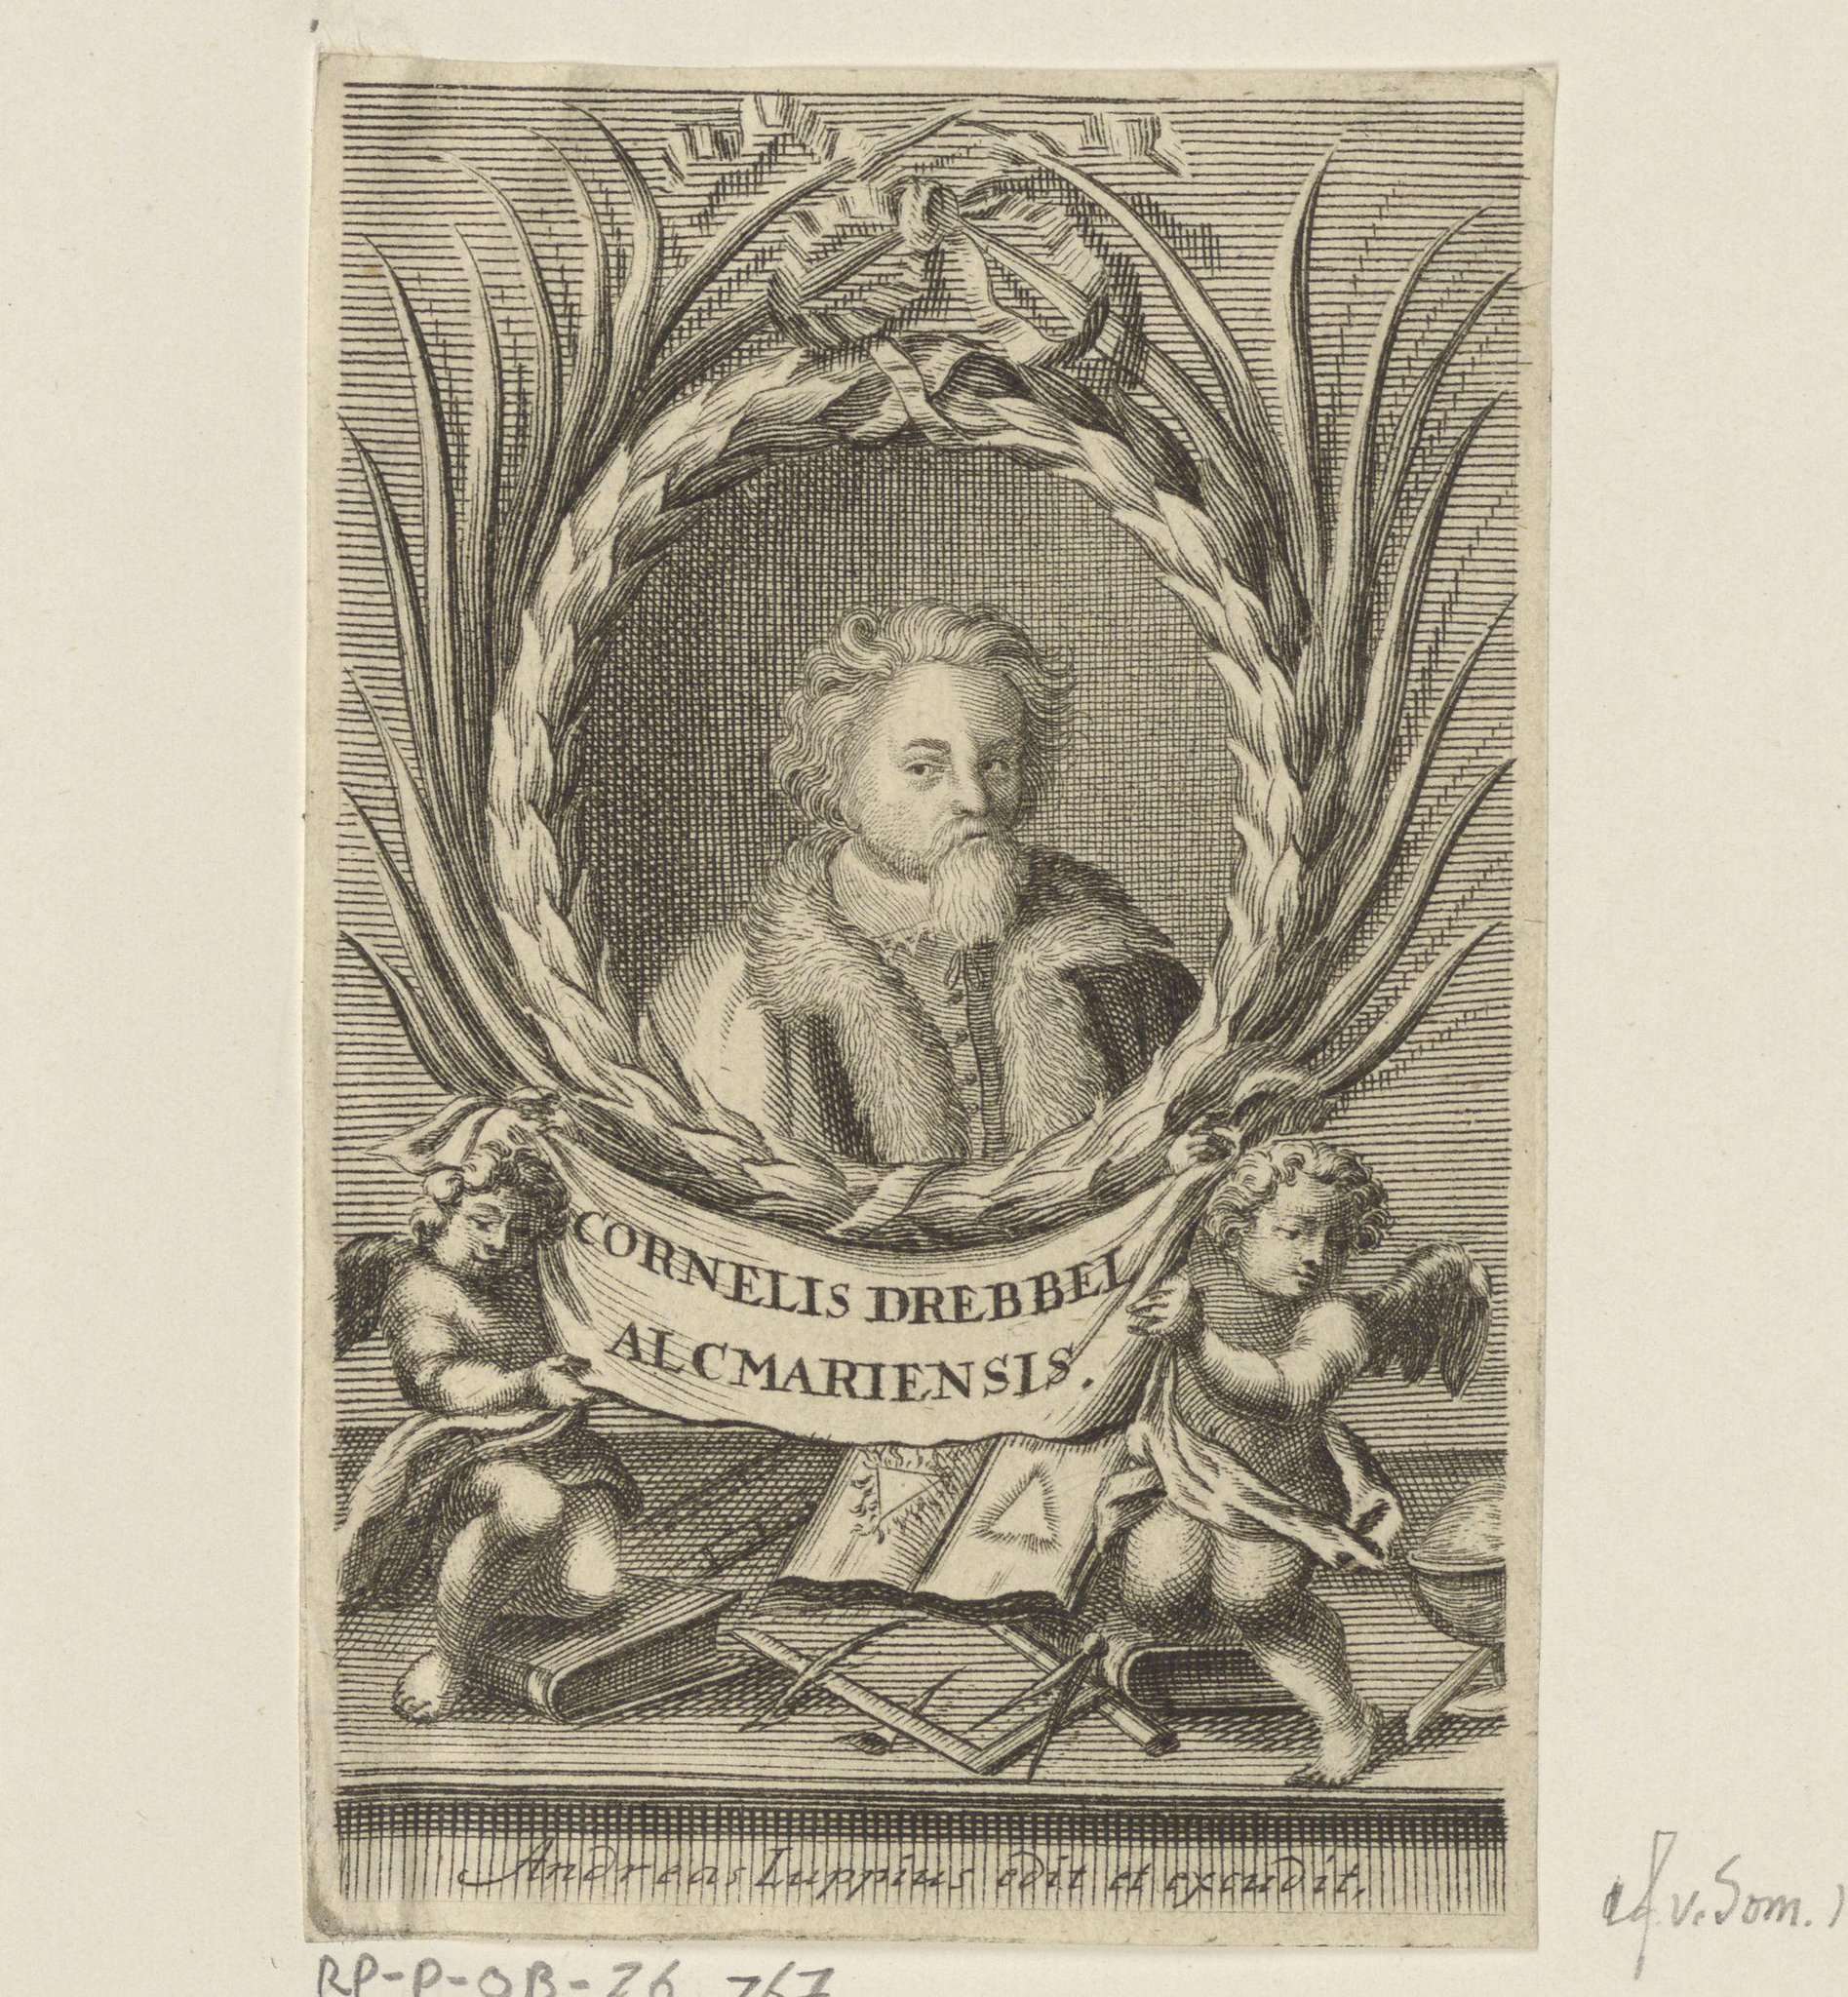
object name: print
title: Portret van Cornelis Jacobsz. Drebbel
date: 1664-1731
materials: paper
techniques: engraving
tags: london, cornelis jacobsz. drebbel, historical persons, portrait, self-portrait of graphic artist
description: Portret in een lauwerkrans en onder geflankeerd door twee putti die een doek ophouden met de naam van de geportretteerde.